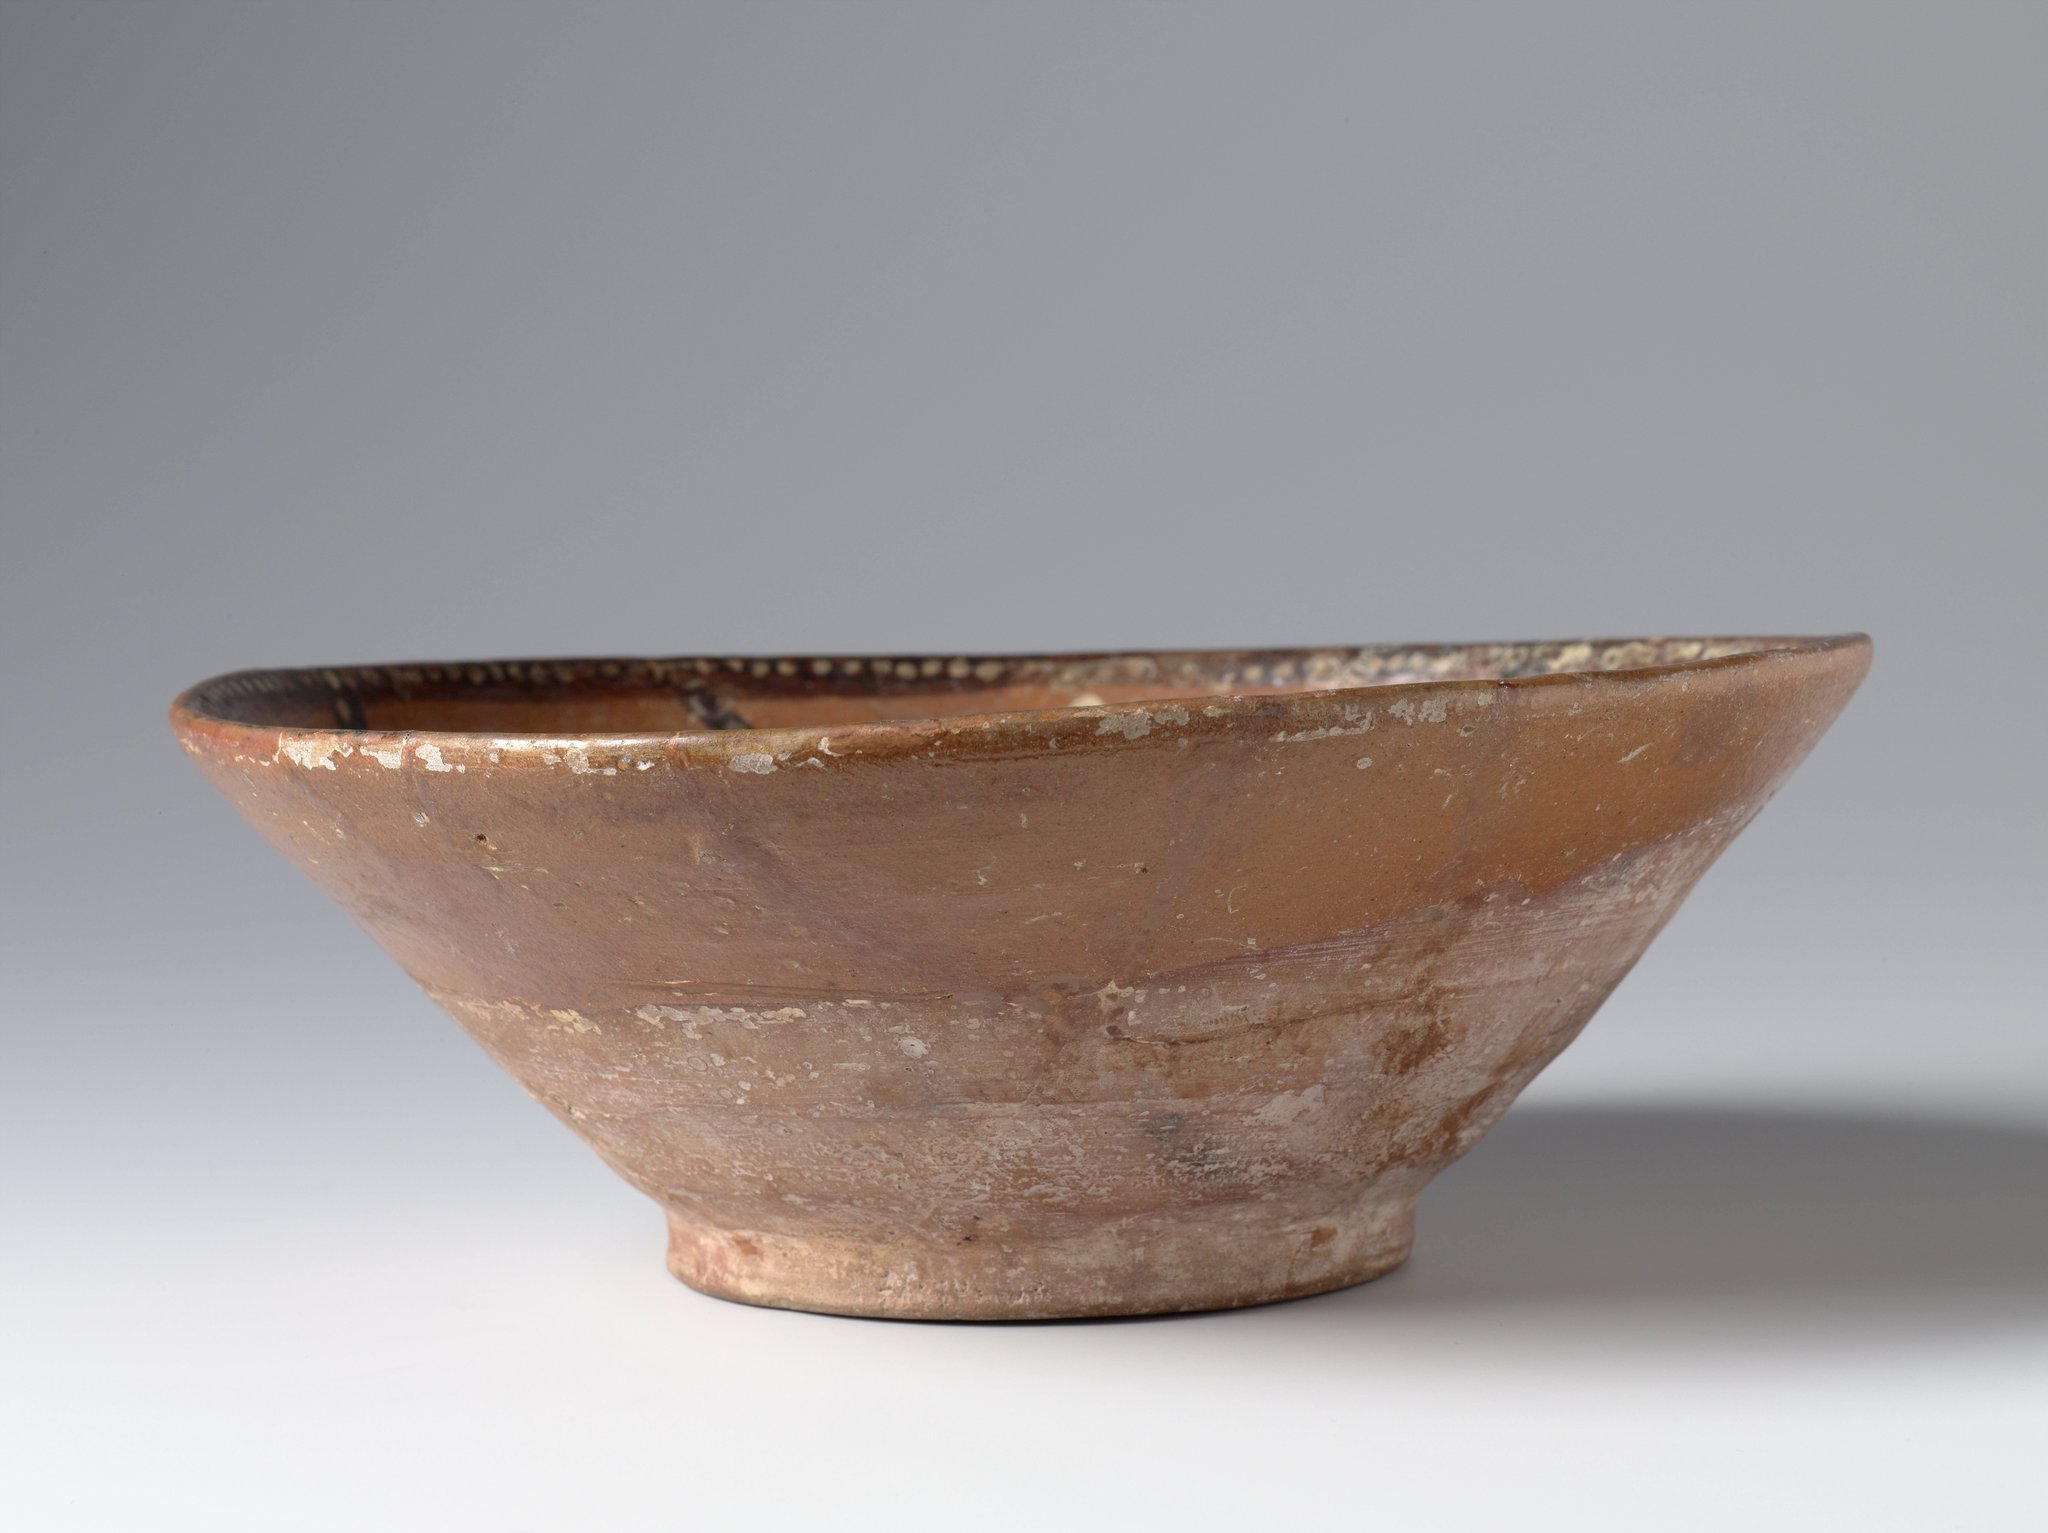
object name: bowl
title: Bowl with nine petal motifs in panels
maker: Anonymous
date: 900-999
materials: earthenware, glaze, paint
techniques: firing, turning, vitrification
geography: samarqand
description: Kom van roodbakkend aardewerk met een witte en een bruine slib-decoratie onder een transparant loodglazuur. De binnenzijde is verdeeld in zeven vakken met daarin negen bladmotieven.